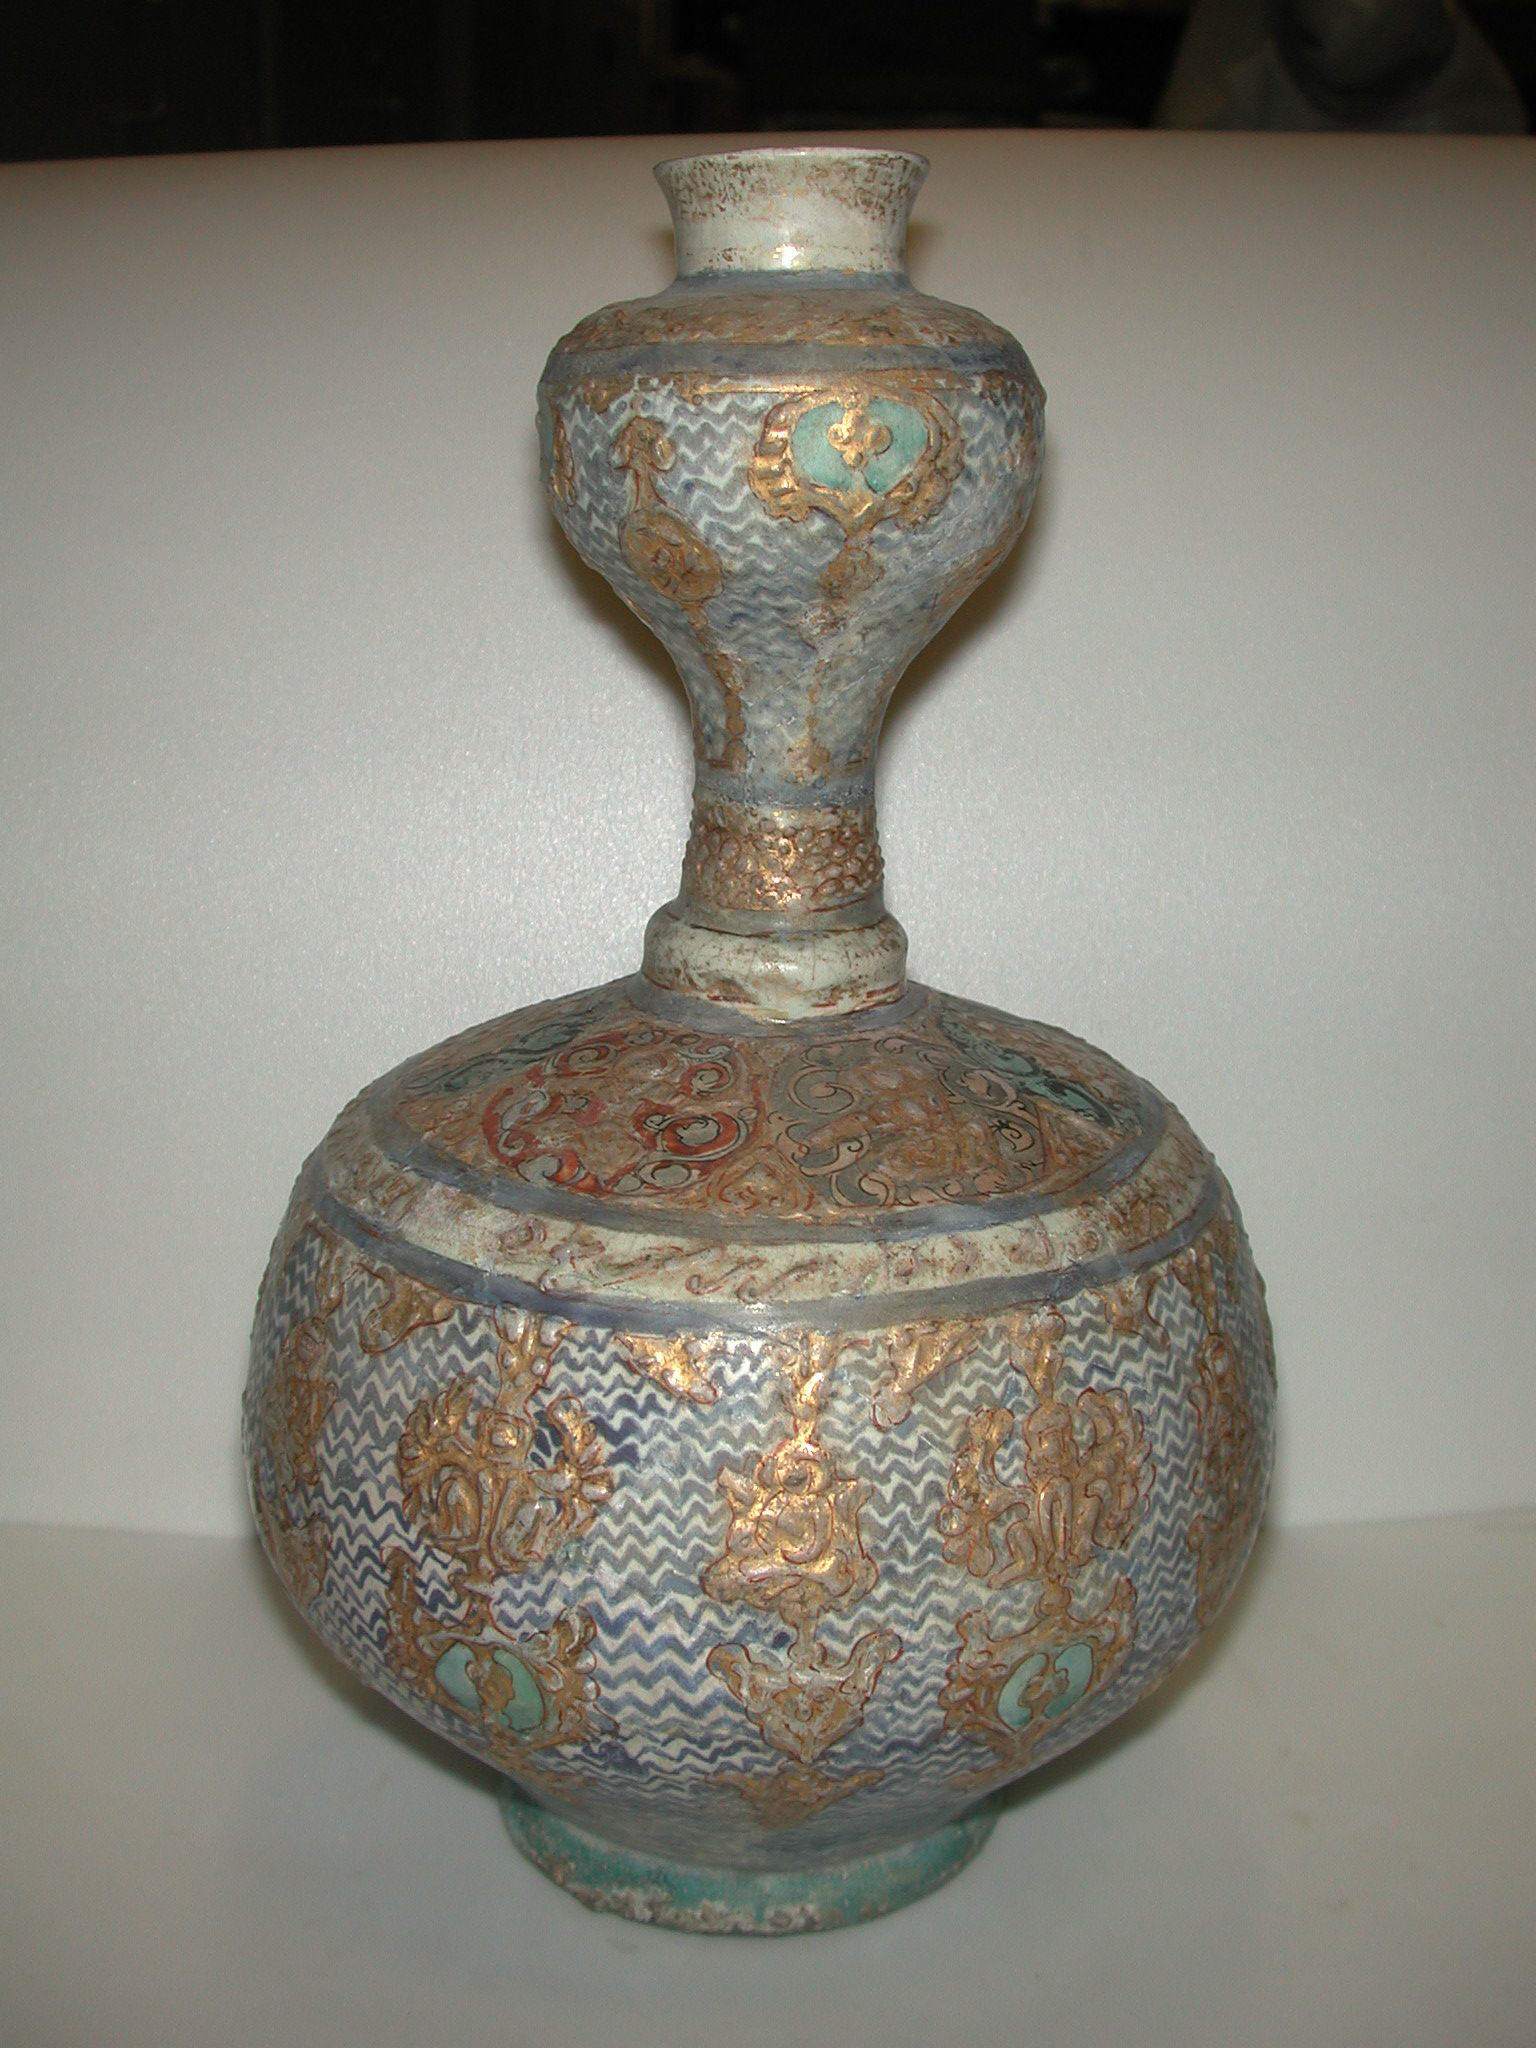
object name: bottle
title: Gilded Mina'i Ceramic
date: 1167-1233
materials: glaze, stonepaste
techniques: gilding, overglaze, painting, polychrome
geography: iran